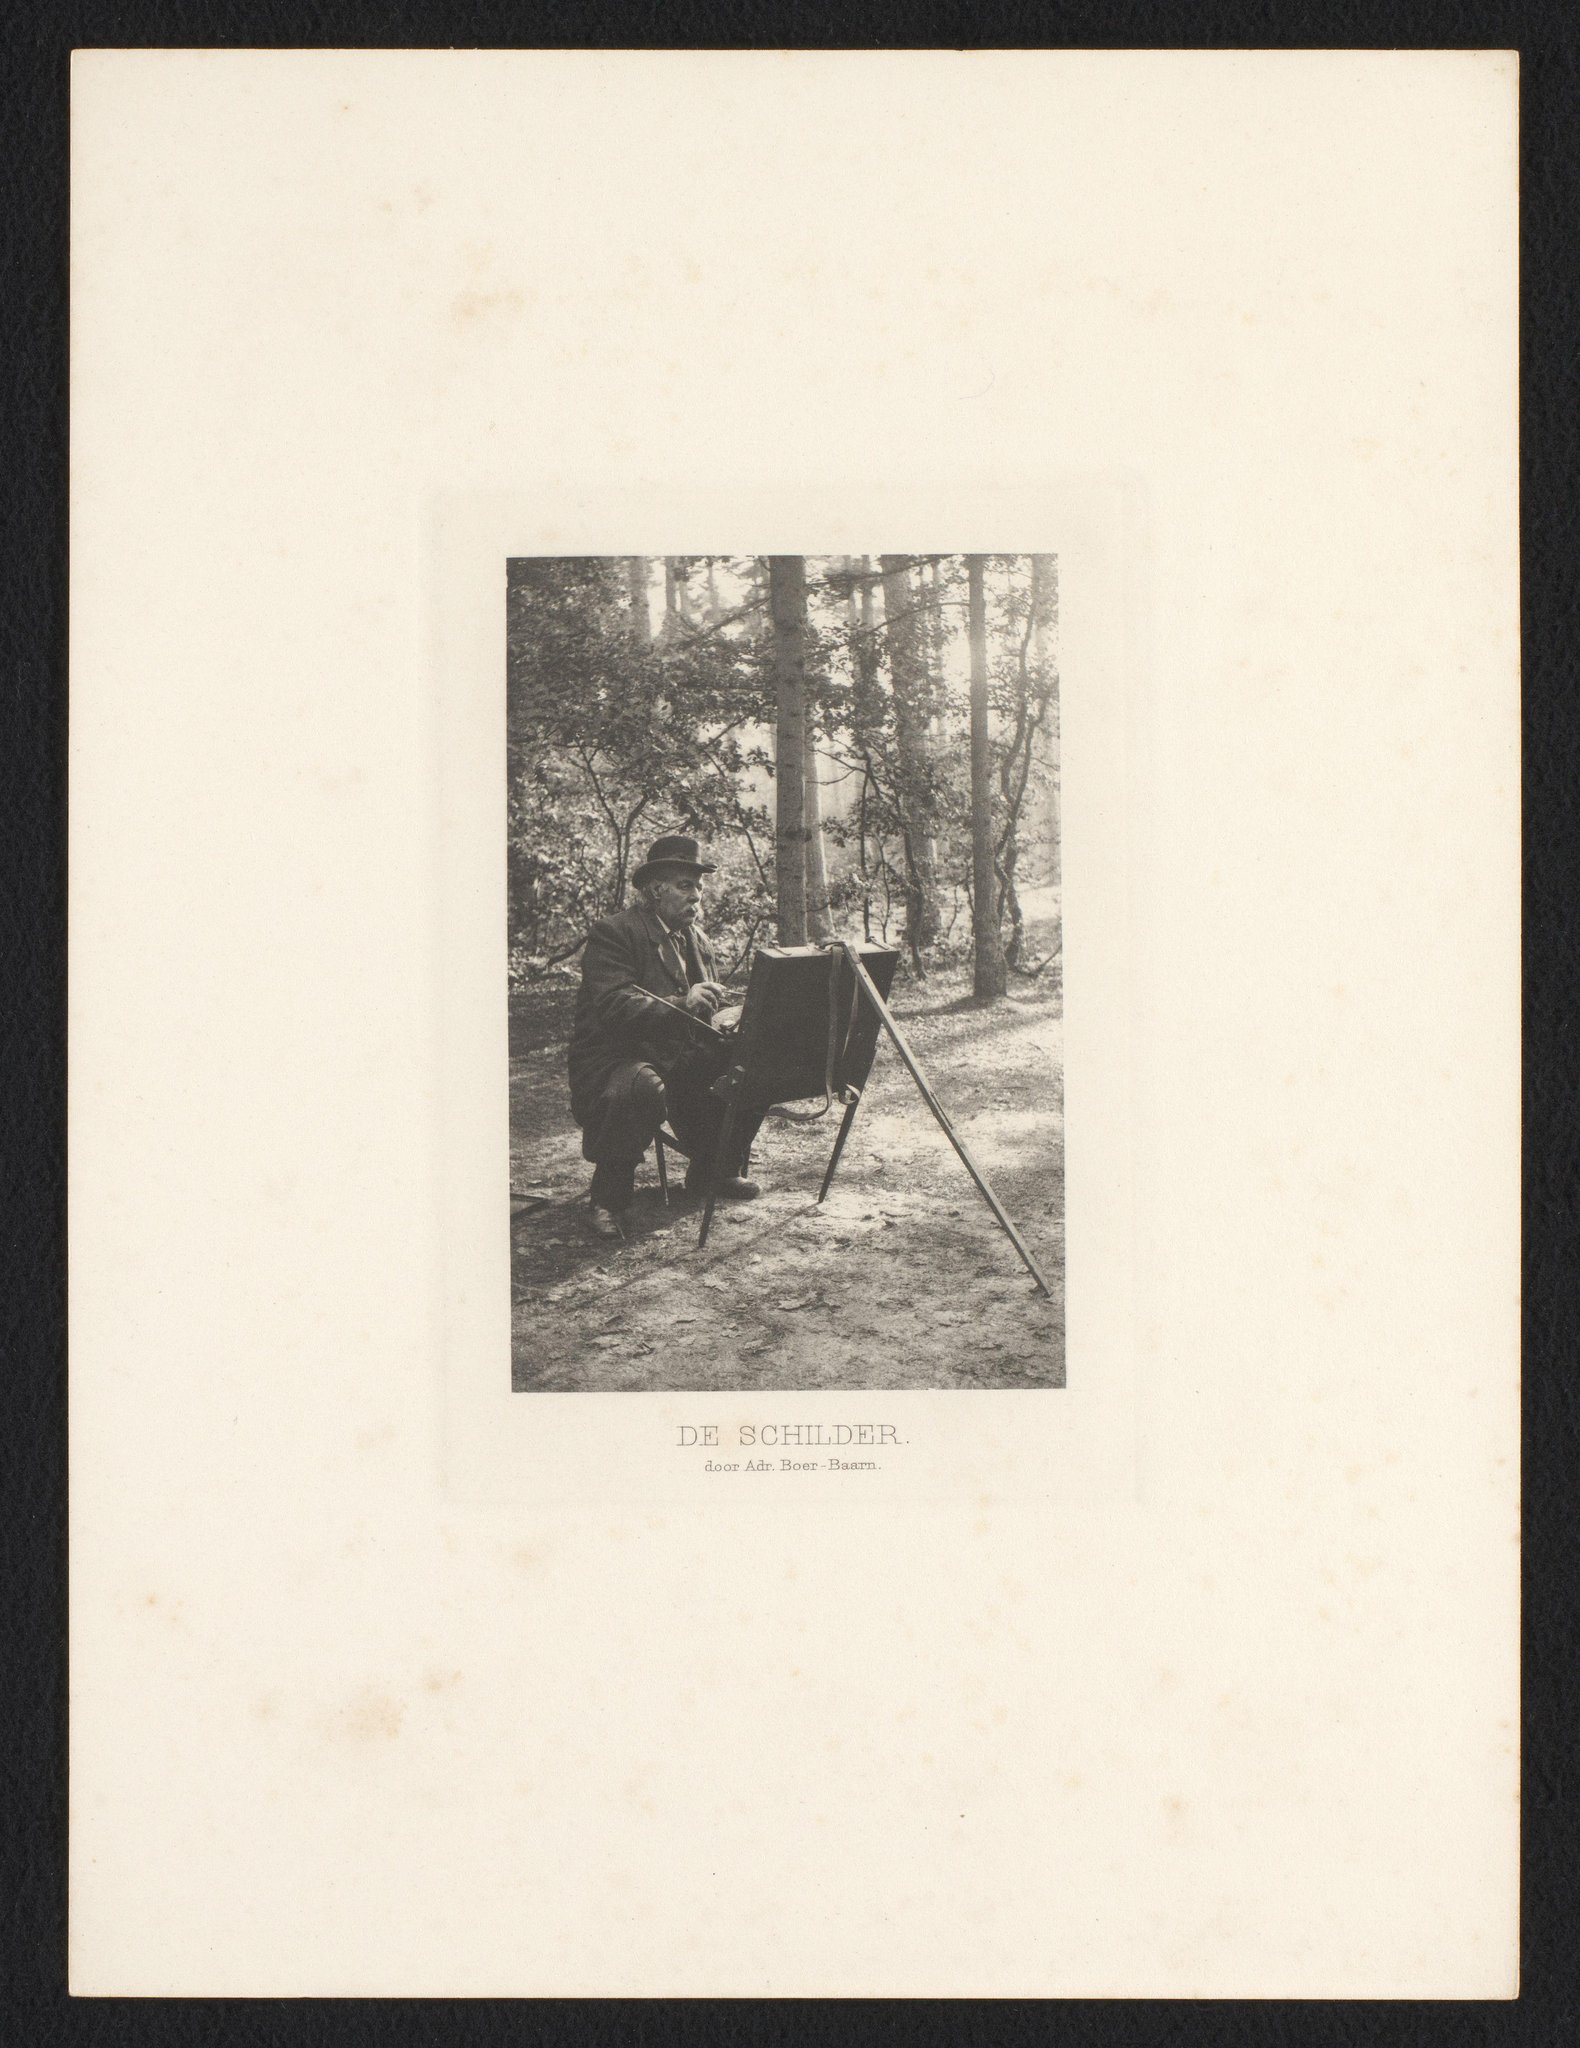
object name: photomechanical print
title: De schilder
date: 1898-1903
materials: paper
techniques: photoaquatint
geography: netherlands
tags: portrait, self-portrait of painter